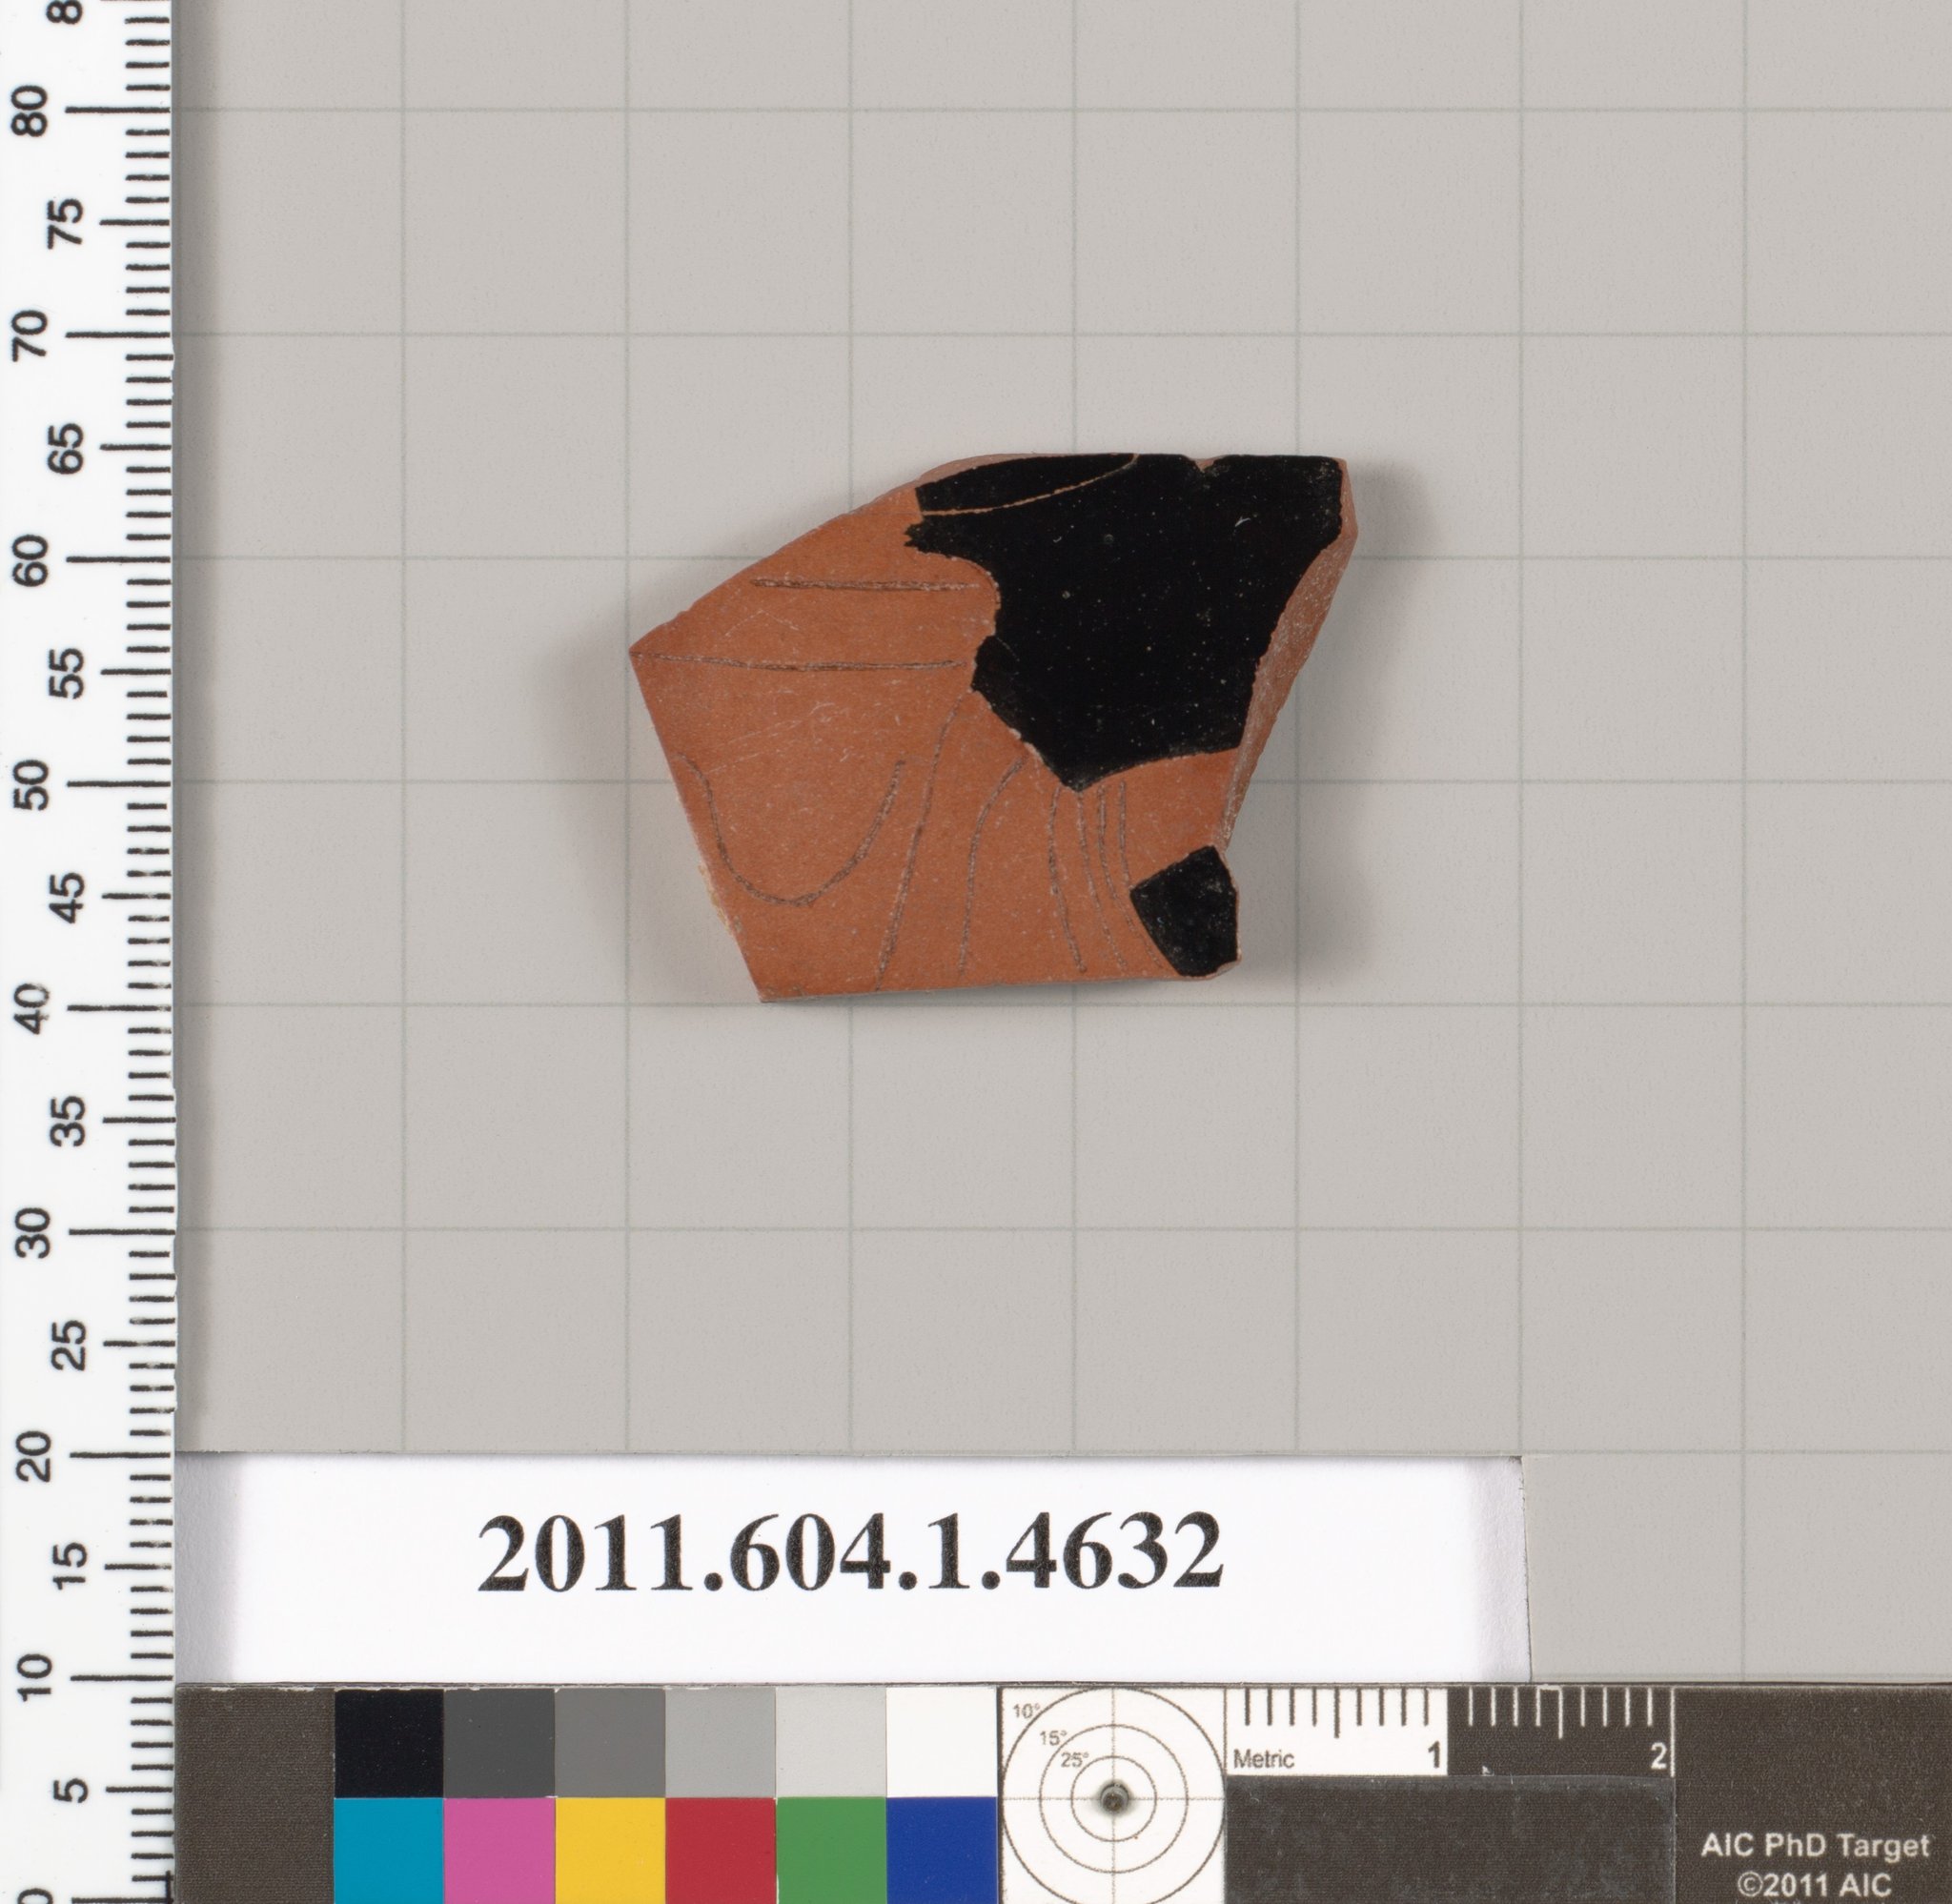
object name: kylix fragment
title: Terracotta fragment of a kylix (drinking cup)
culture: greek, attic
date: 475-451 BCE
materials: terracotta